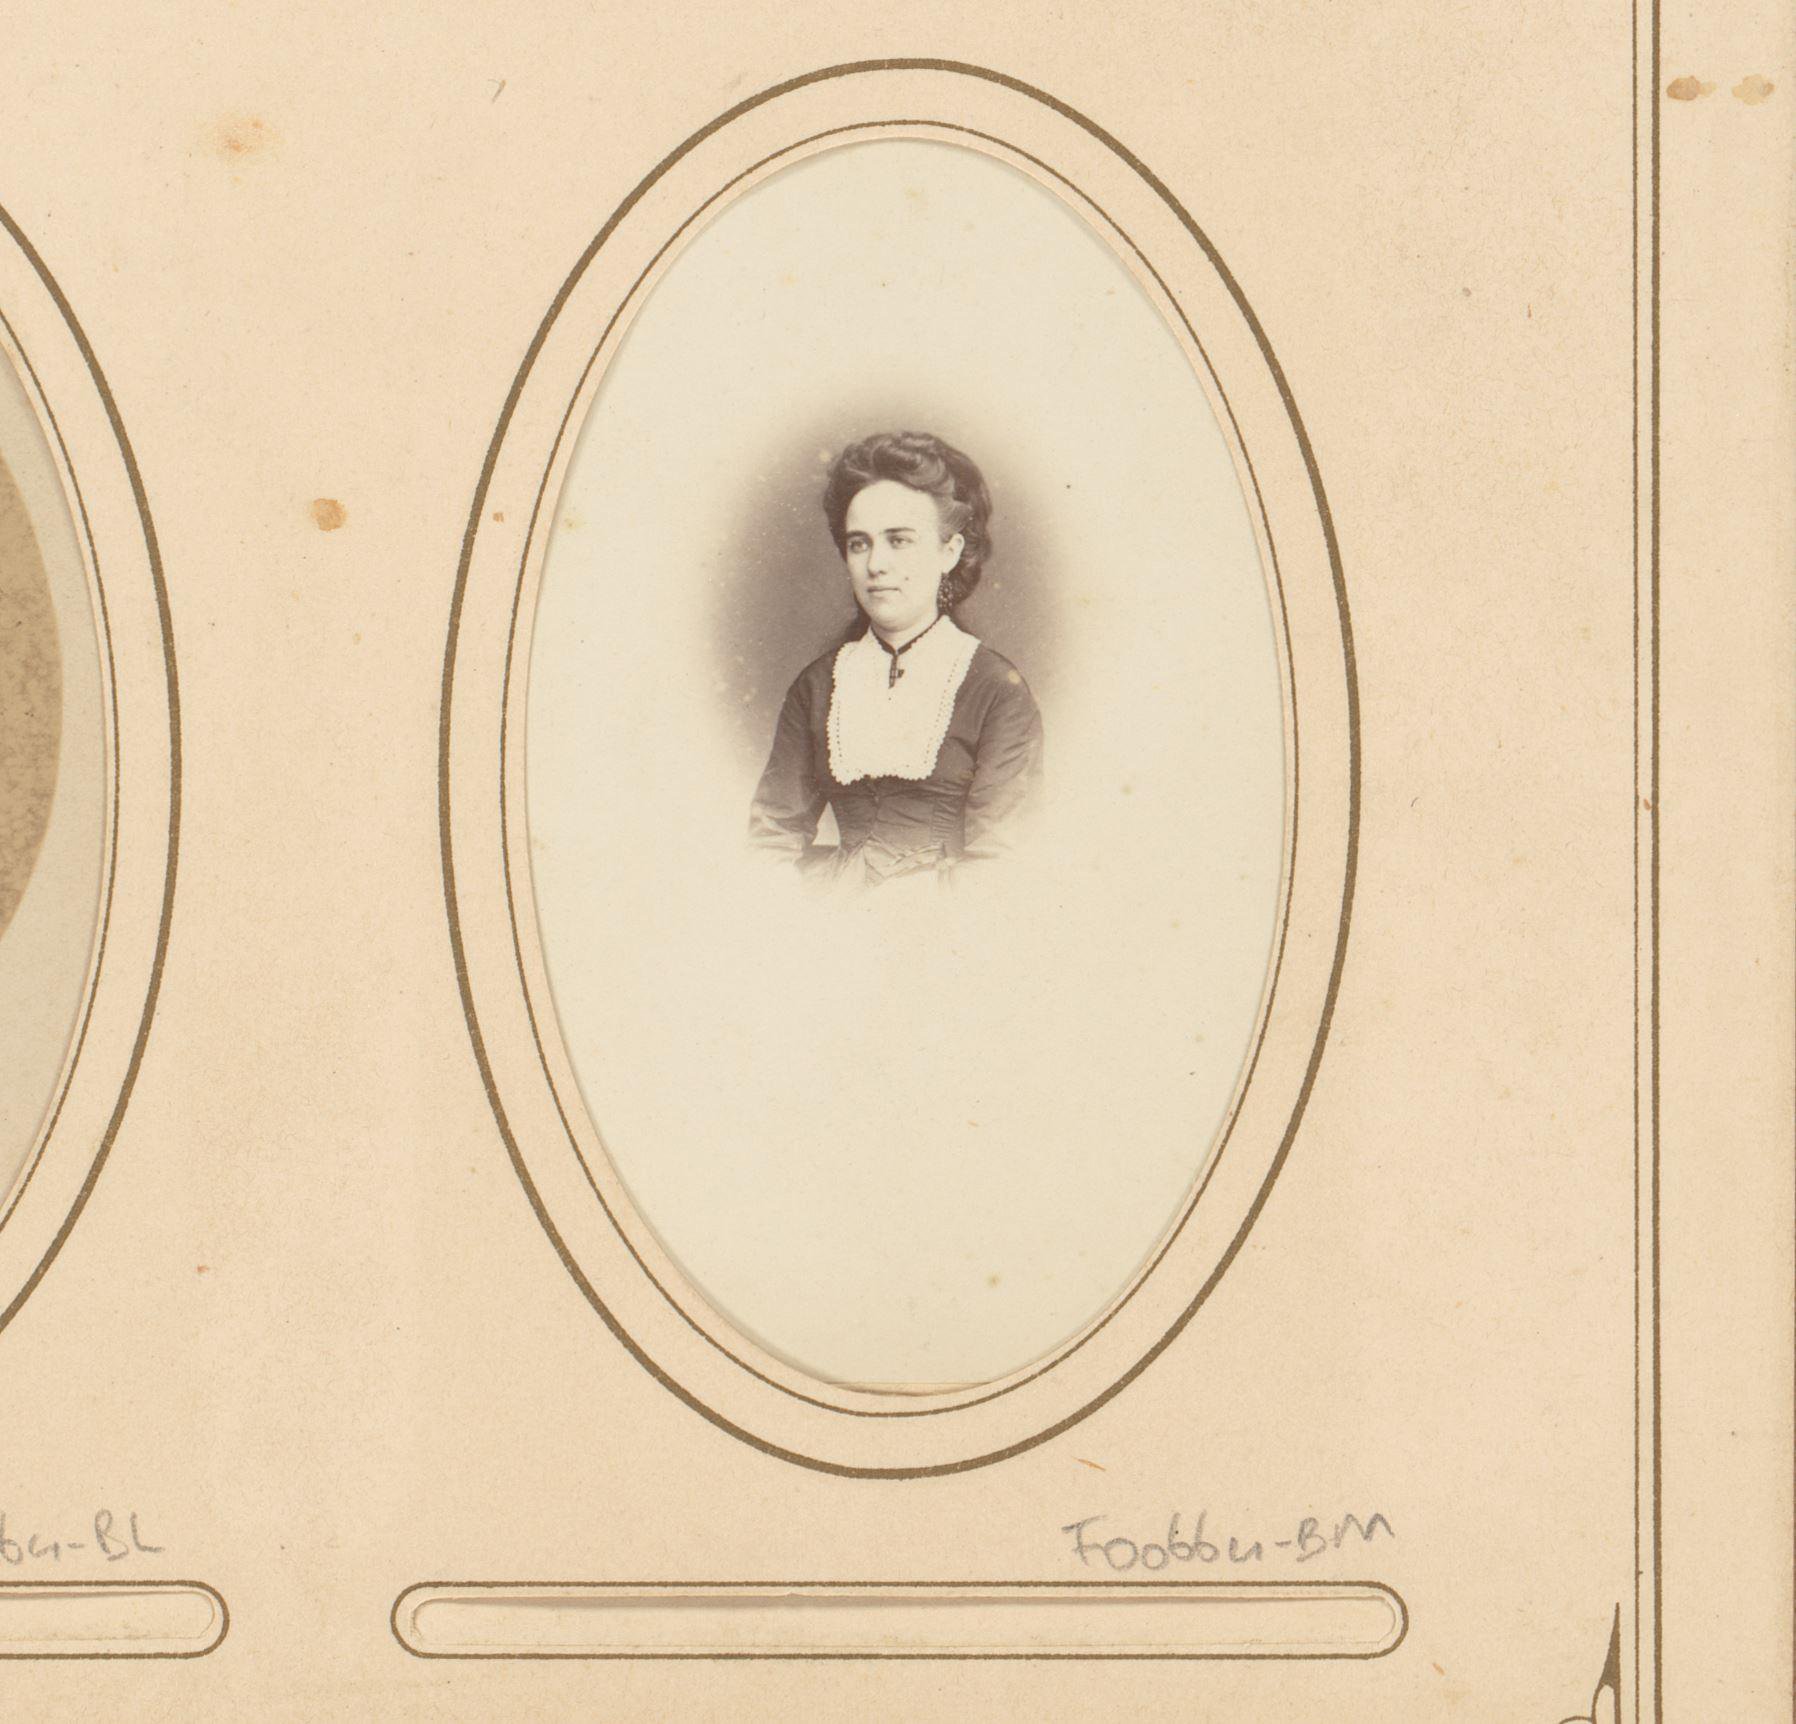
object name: album leaf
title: Portret van een vrouw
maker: c. perret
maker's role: fotograaf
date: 1870-1885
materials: cardboard, photographic support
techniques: albumen print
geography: java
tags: historical persons - bb - woman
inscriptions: inscription: ‘C. Perret/ Photograaf/ Java’